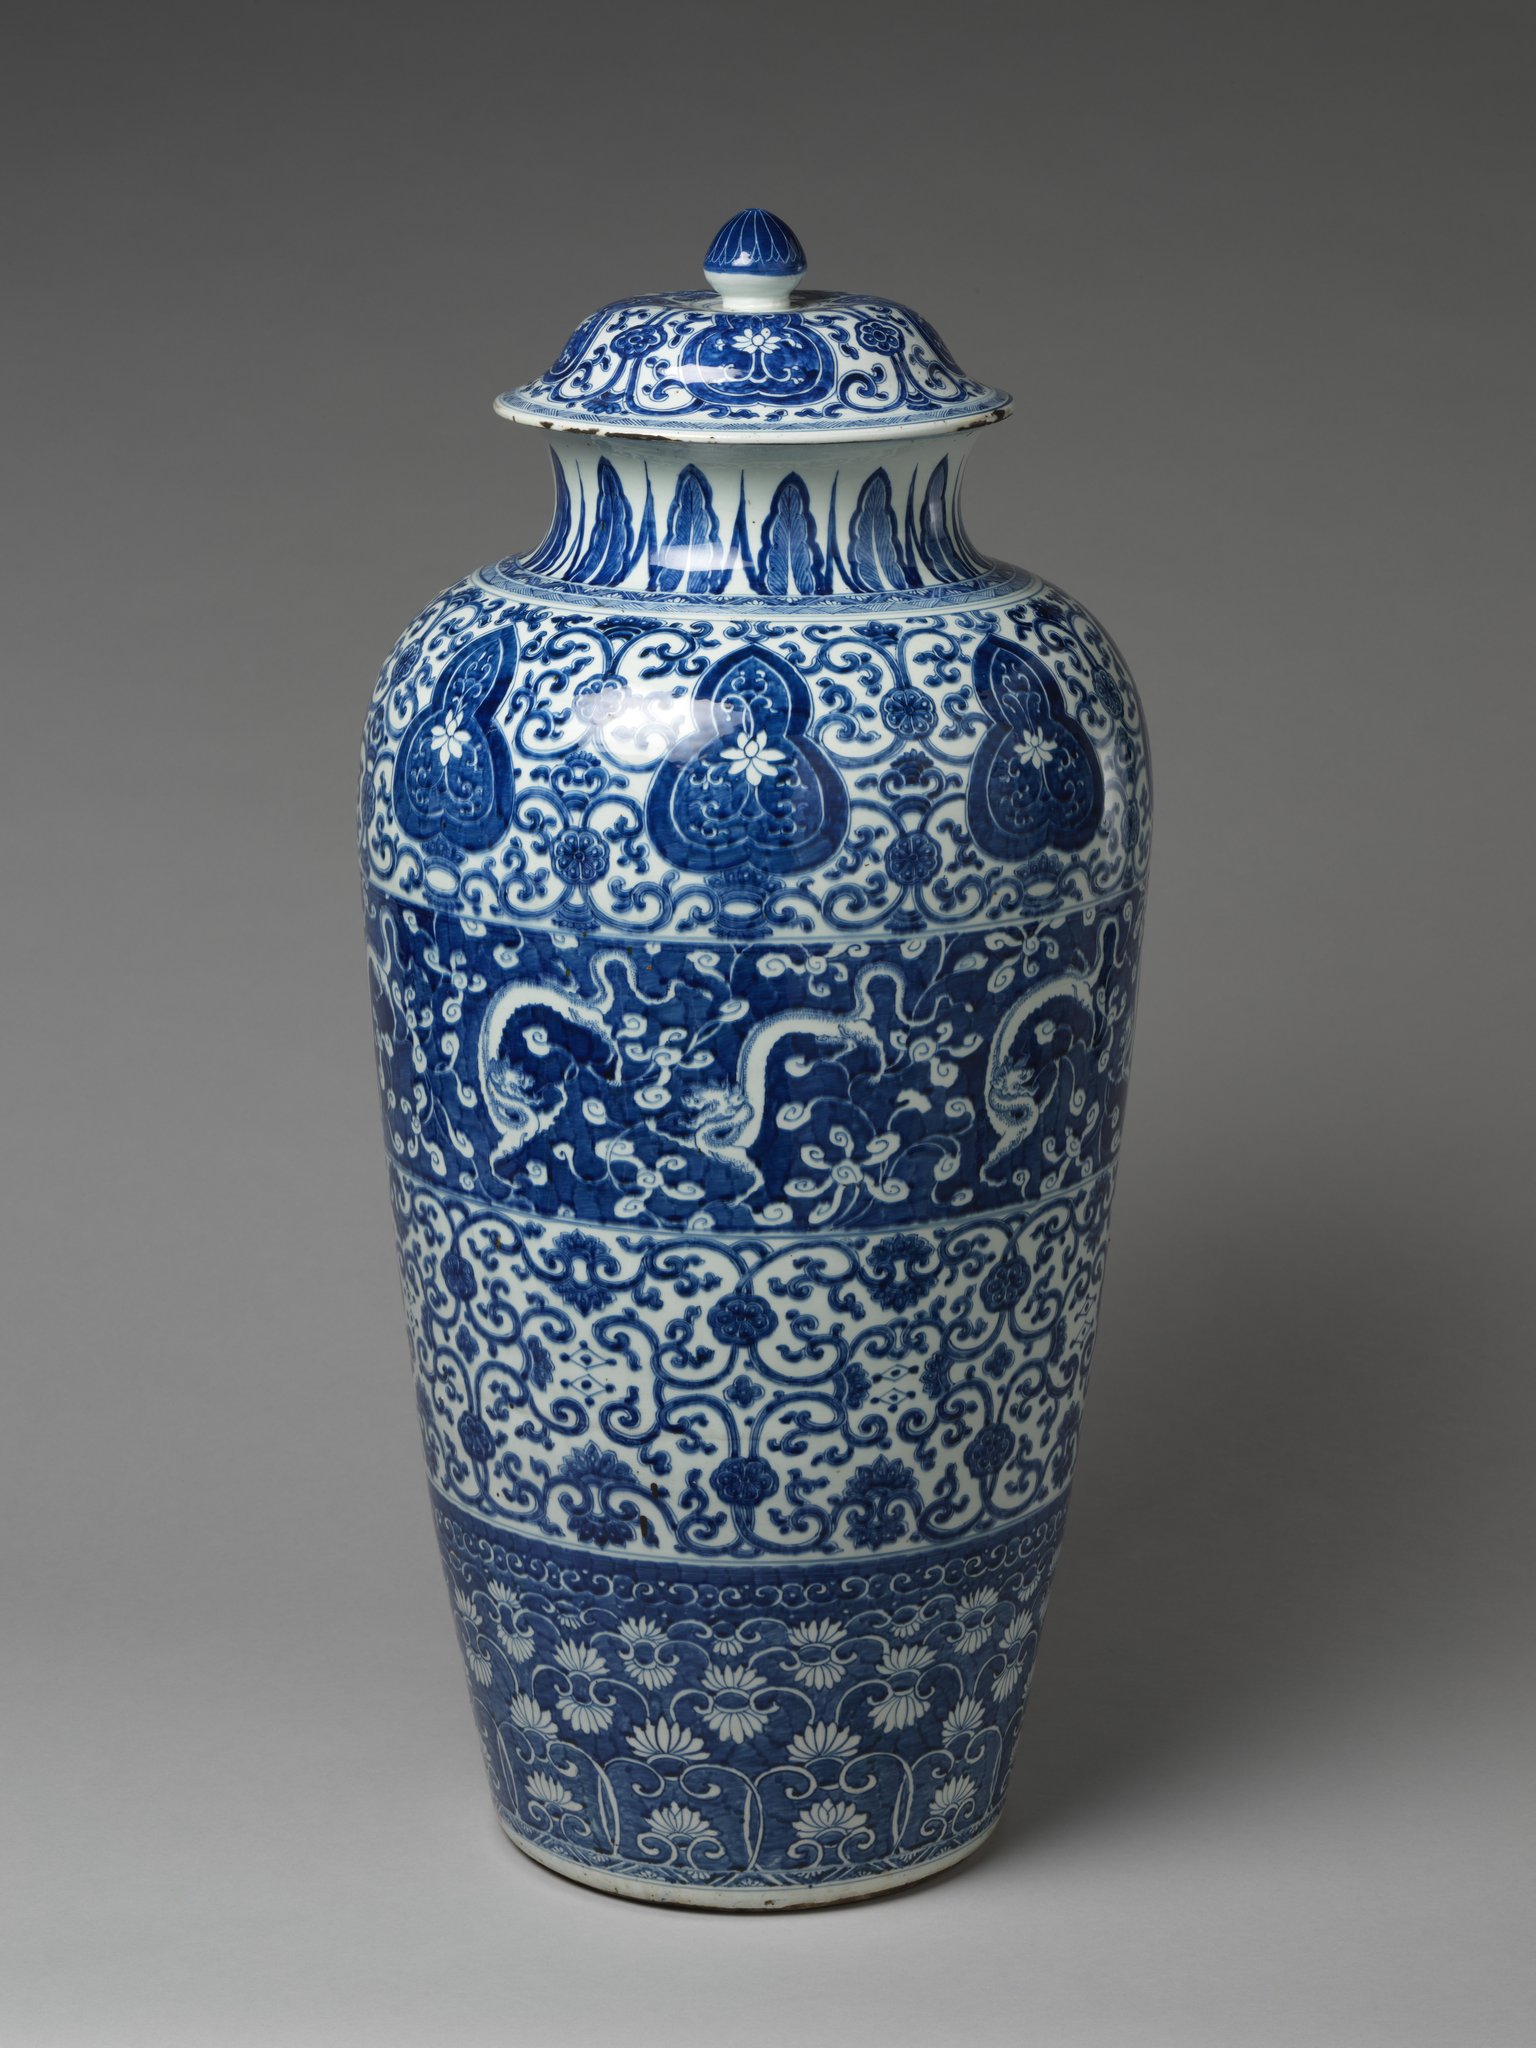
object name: jar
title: Jar with Dragons and Floral Designs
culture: chinese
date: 1667-1733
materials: cobalt, glaze, porcelain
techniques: painting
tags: dragons